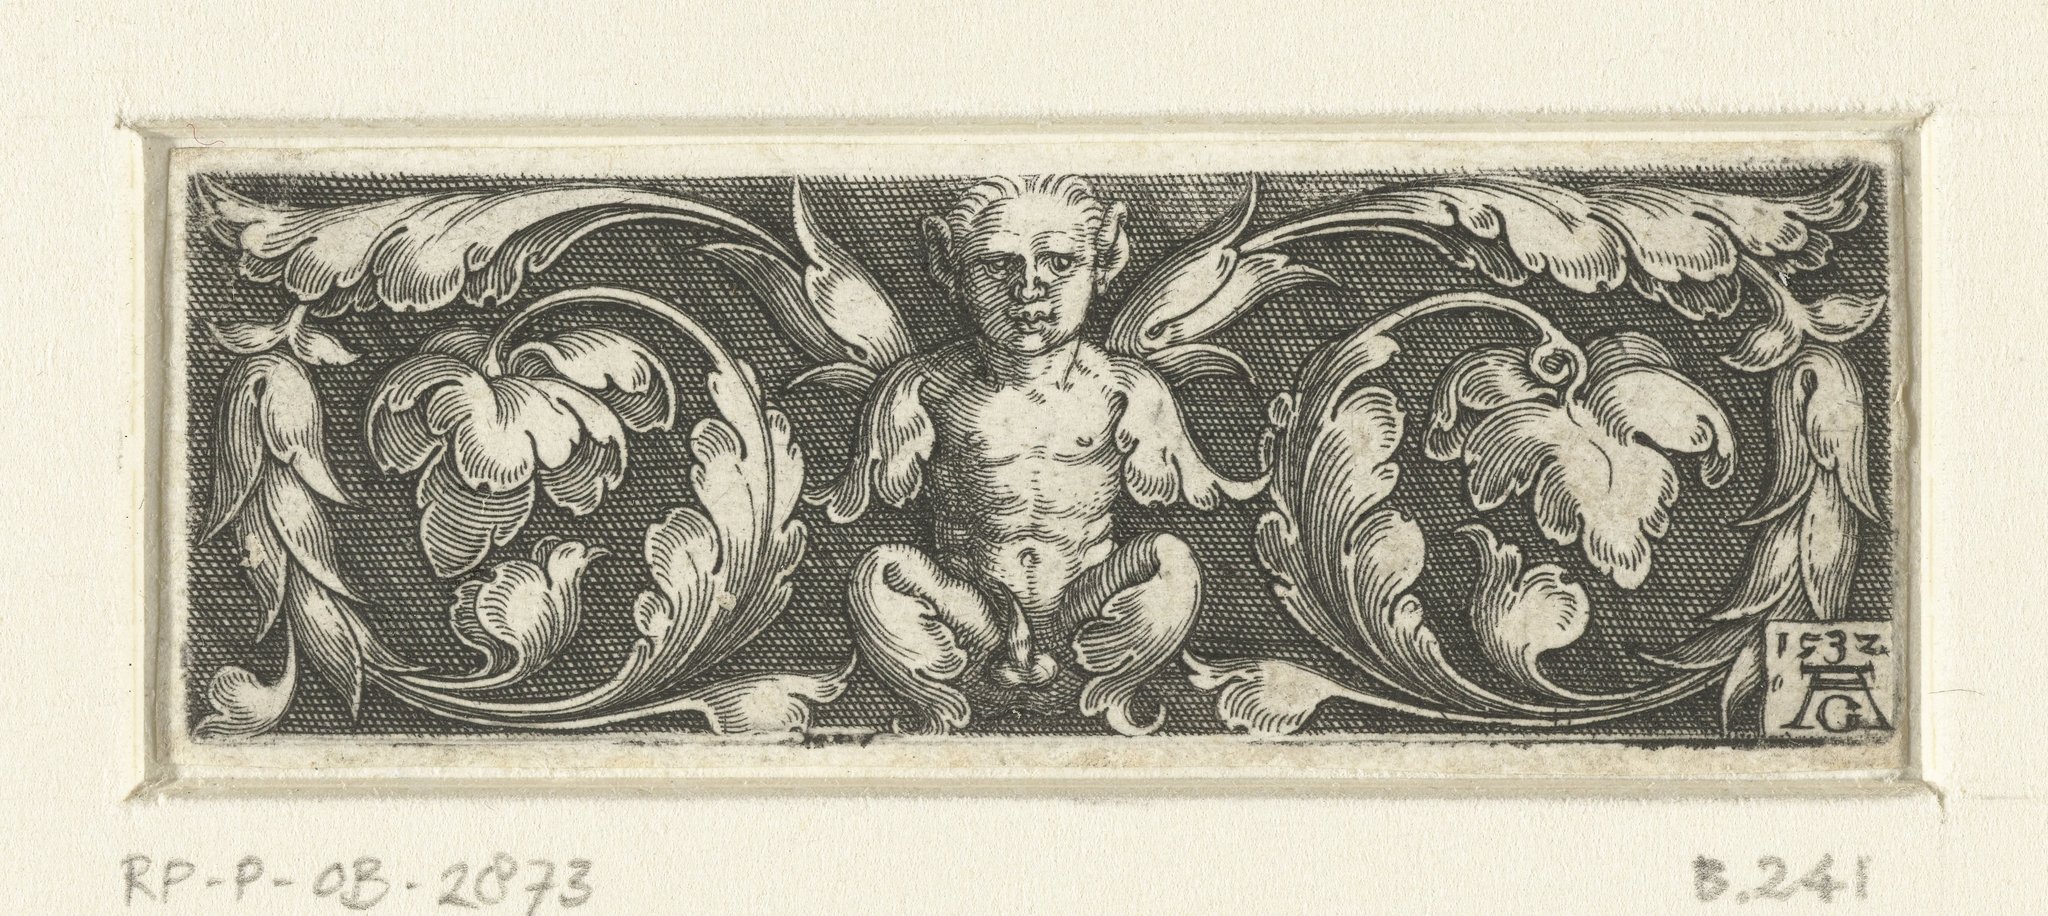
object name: print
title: Fries met sater tussen twee bladranken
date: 1532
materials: paper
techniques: engraving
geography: germany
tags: satyr(s) (in general), foliage, tendrils, branches ~ ornament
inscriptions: number: ‘14’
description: Fries met een gehurkte sater tussen twee bladranken die uit zijn schouders komen.